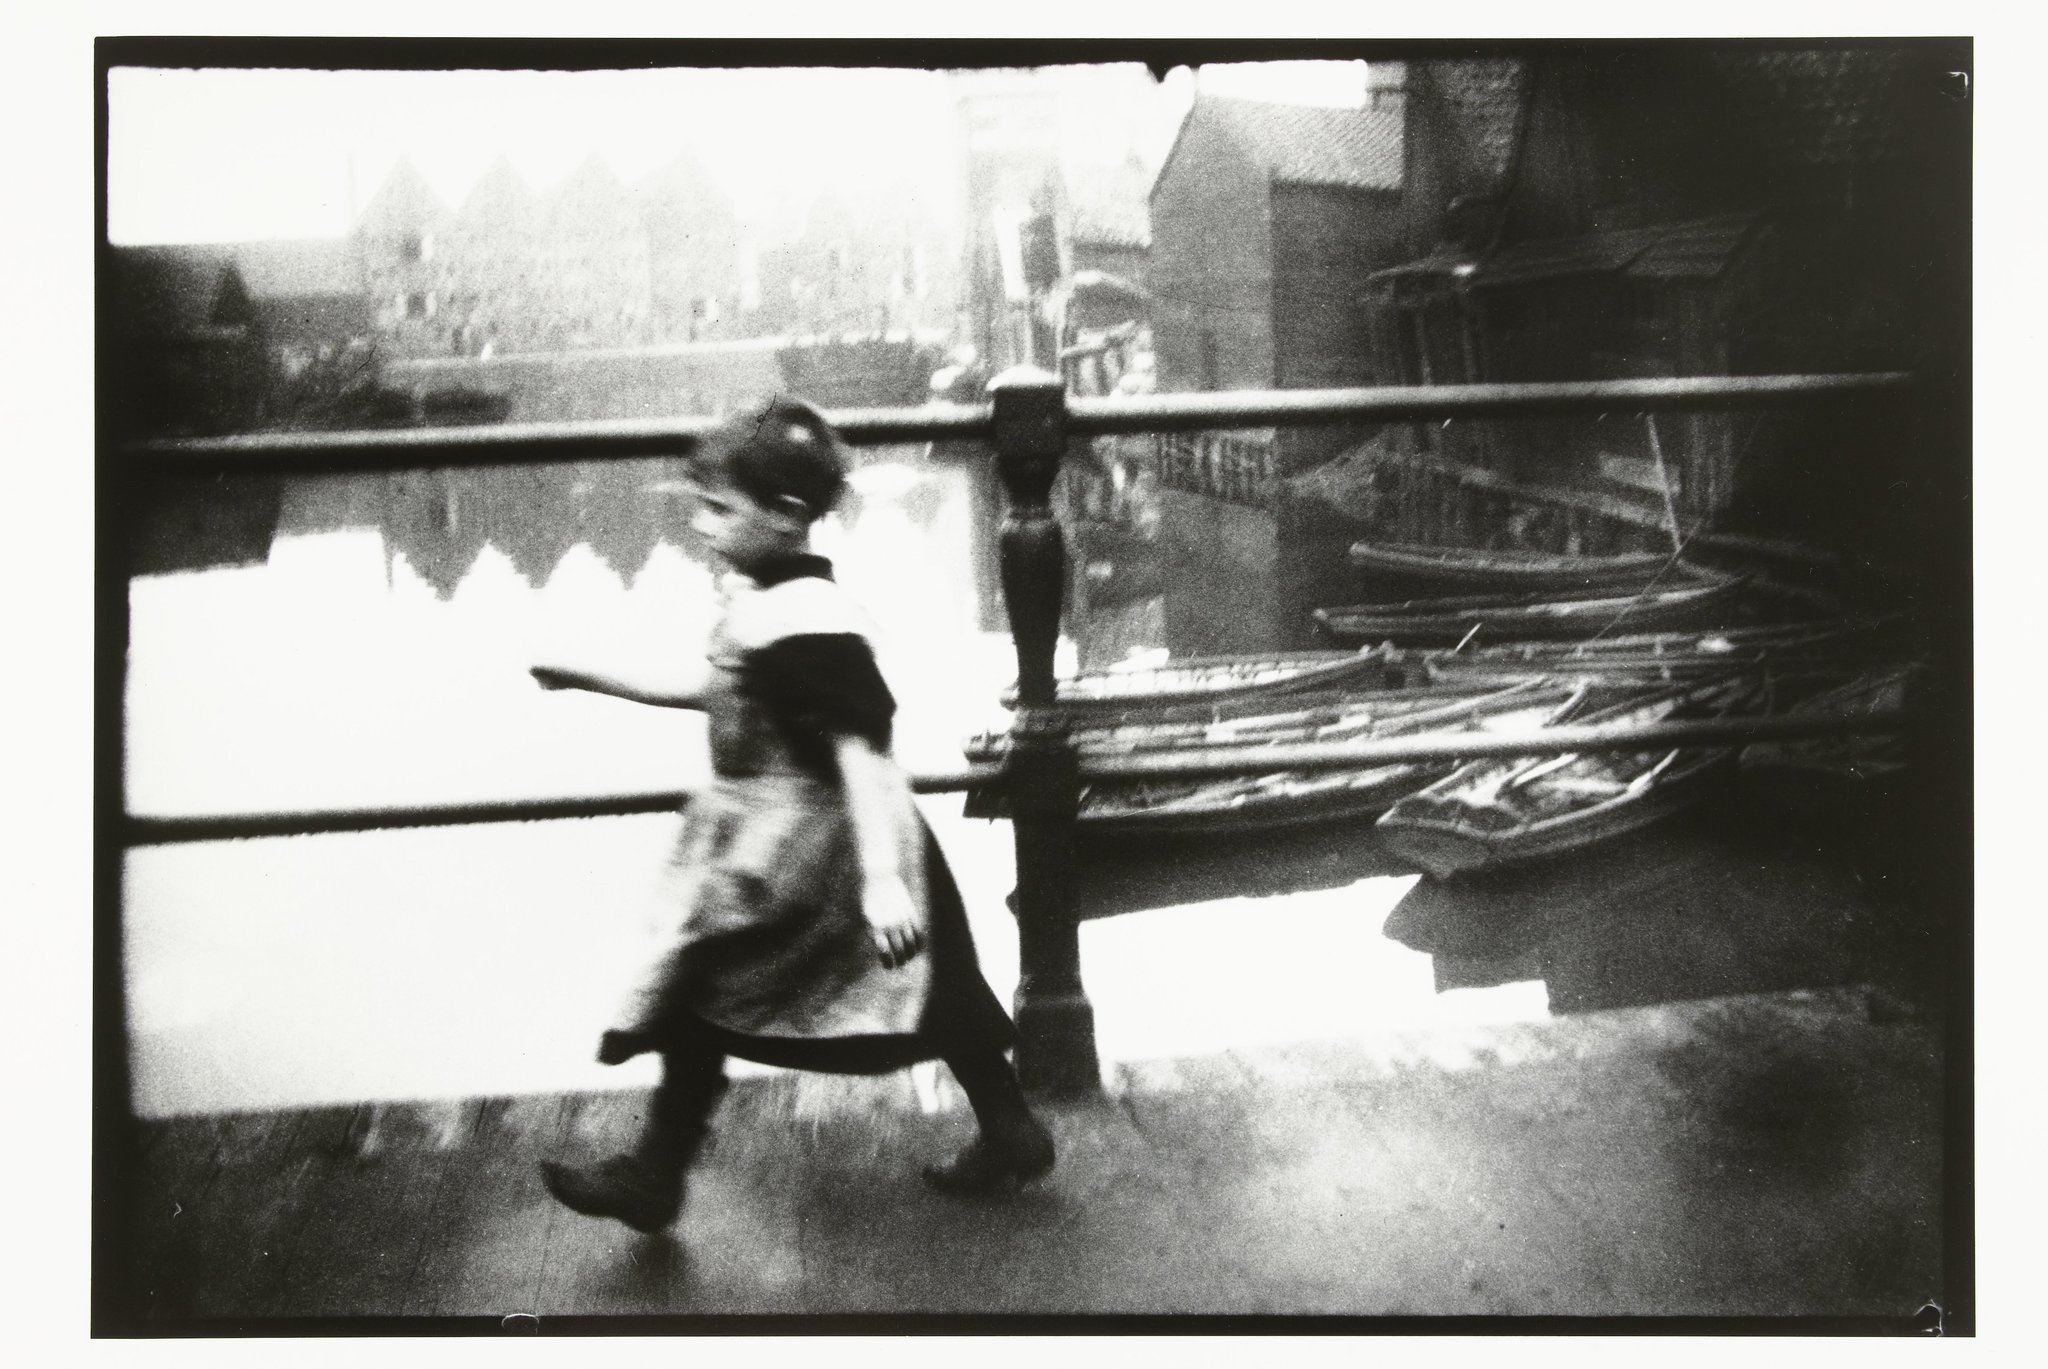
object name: photograph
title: Meisje op de brug van Prinseneiland in Amsterdam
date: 1890-1910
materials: paper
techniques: gelatin silver print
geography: amsterdam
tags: prinseneiland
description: Moderne afdruk van negatief BR 1378 (collectie RKD).